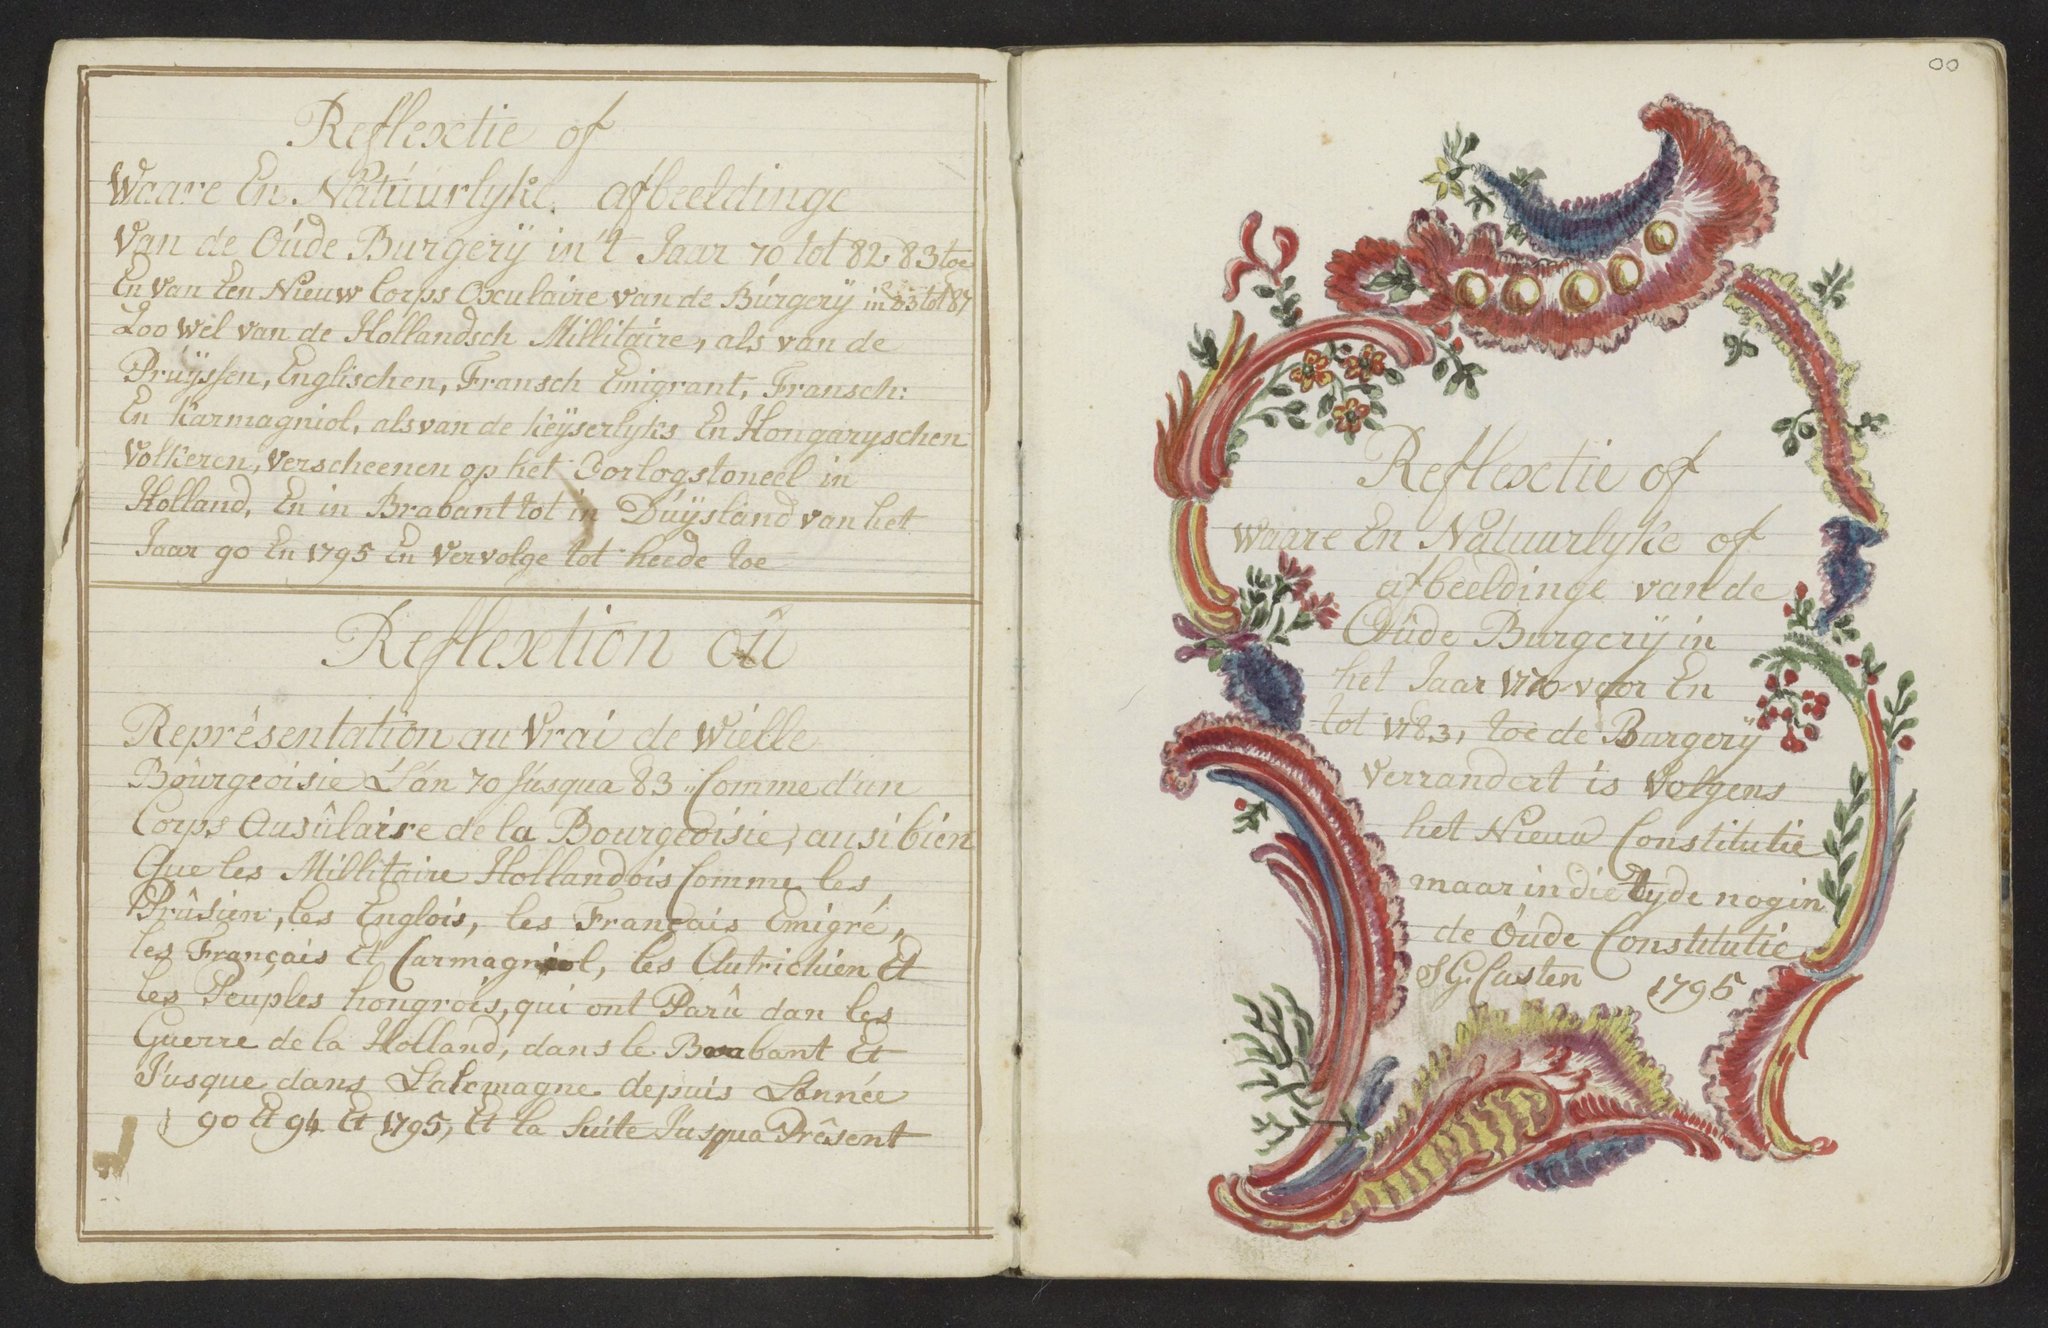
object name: manuscript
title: Titelbladen, 1795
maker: s.g. casten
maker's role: draughtsman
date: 1795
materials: paper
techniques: writing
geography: amsterdam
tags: patriots (1780-1795)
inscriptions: date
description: Twee bladzijden met de titels van het album in het Nederlands en Frans. Rechts de titel van het eerste hoofdstuk in het Nederlands binnen een gekleurde cartouche. Onderdeel van het schetsboek met gekleurde tekeningen van de uniformen van militairen en leden van de schutterij uit de periode 1770 tot 1795-1796.